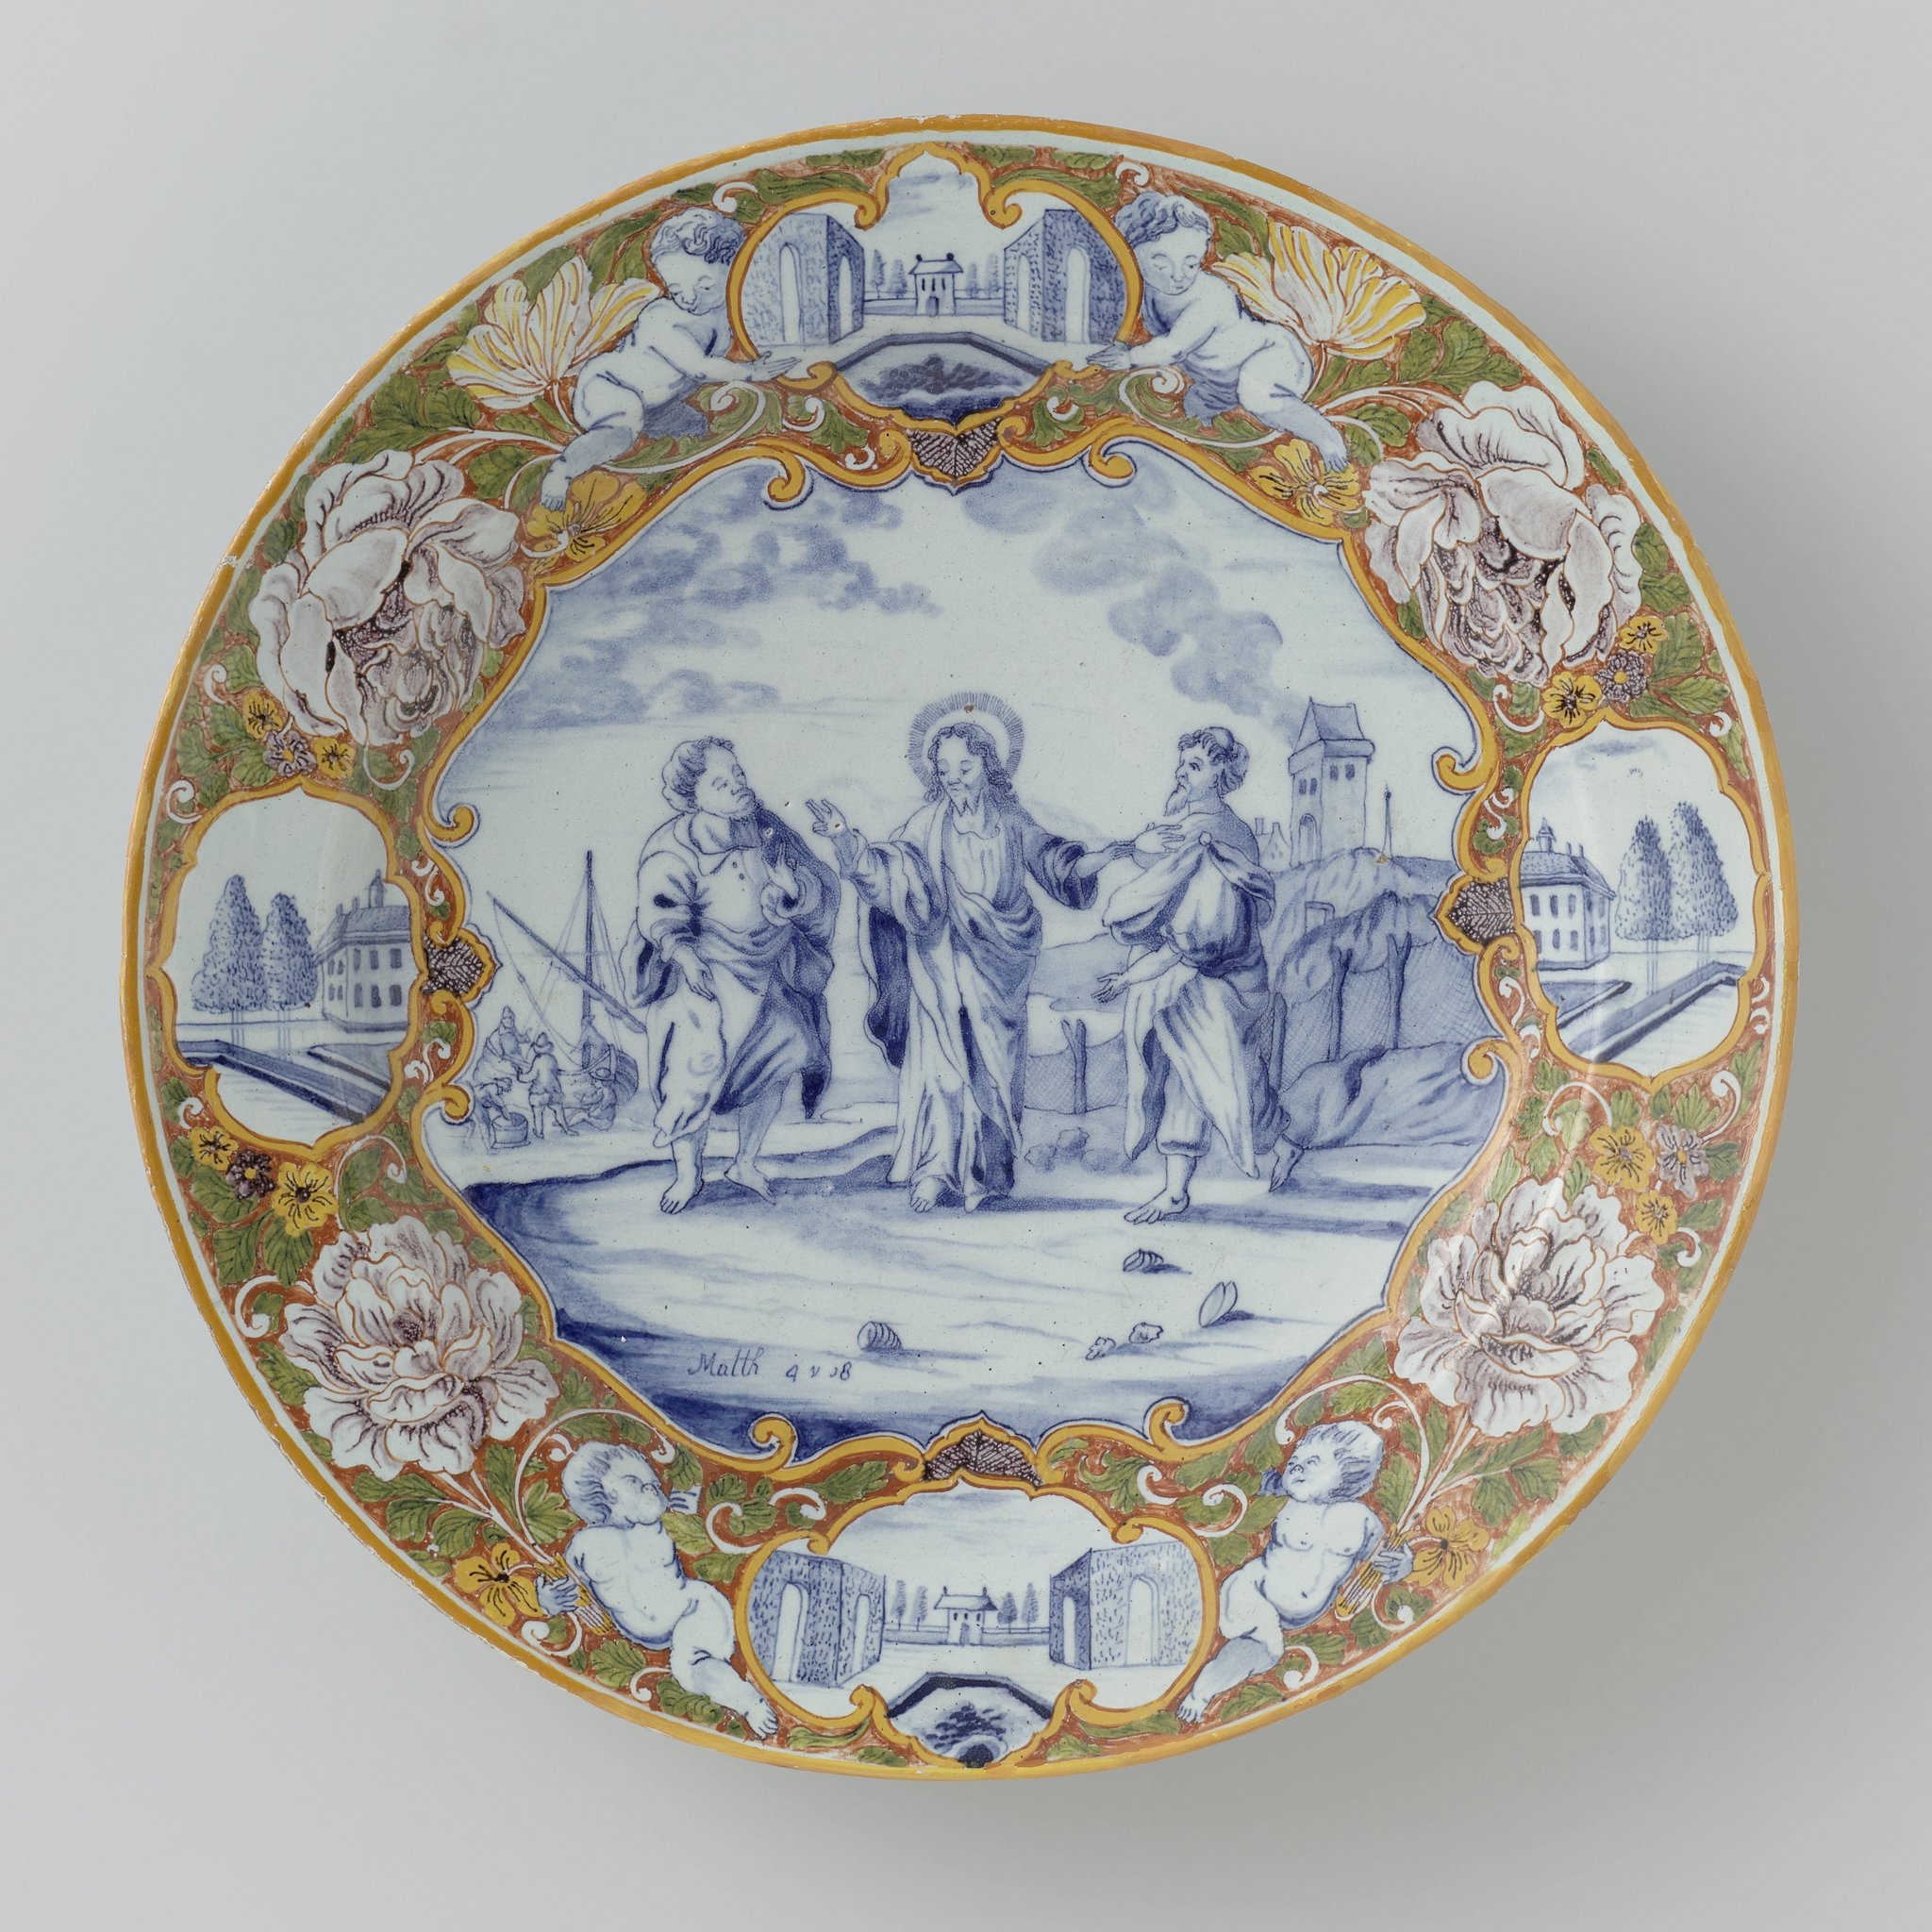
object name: platter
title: Schotel met de roeping van Petrus en Andreas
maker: Anonymous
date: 1750-1770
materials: faience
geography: delft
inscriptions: inscription: ‘Matth 4 v 18’, seal: ‘130’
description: Schotel van faïence. In blauw op het plat de voorstelling van Mattheus 14 vers 18. Daar omheen een veelkleurige bloemenrand met putti en landschapjes in blauw.